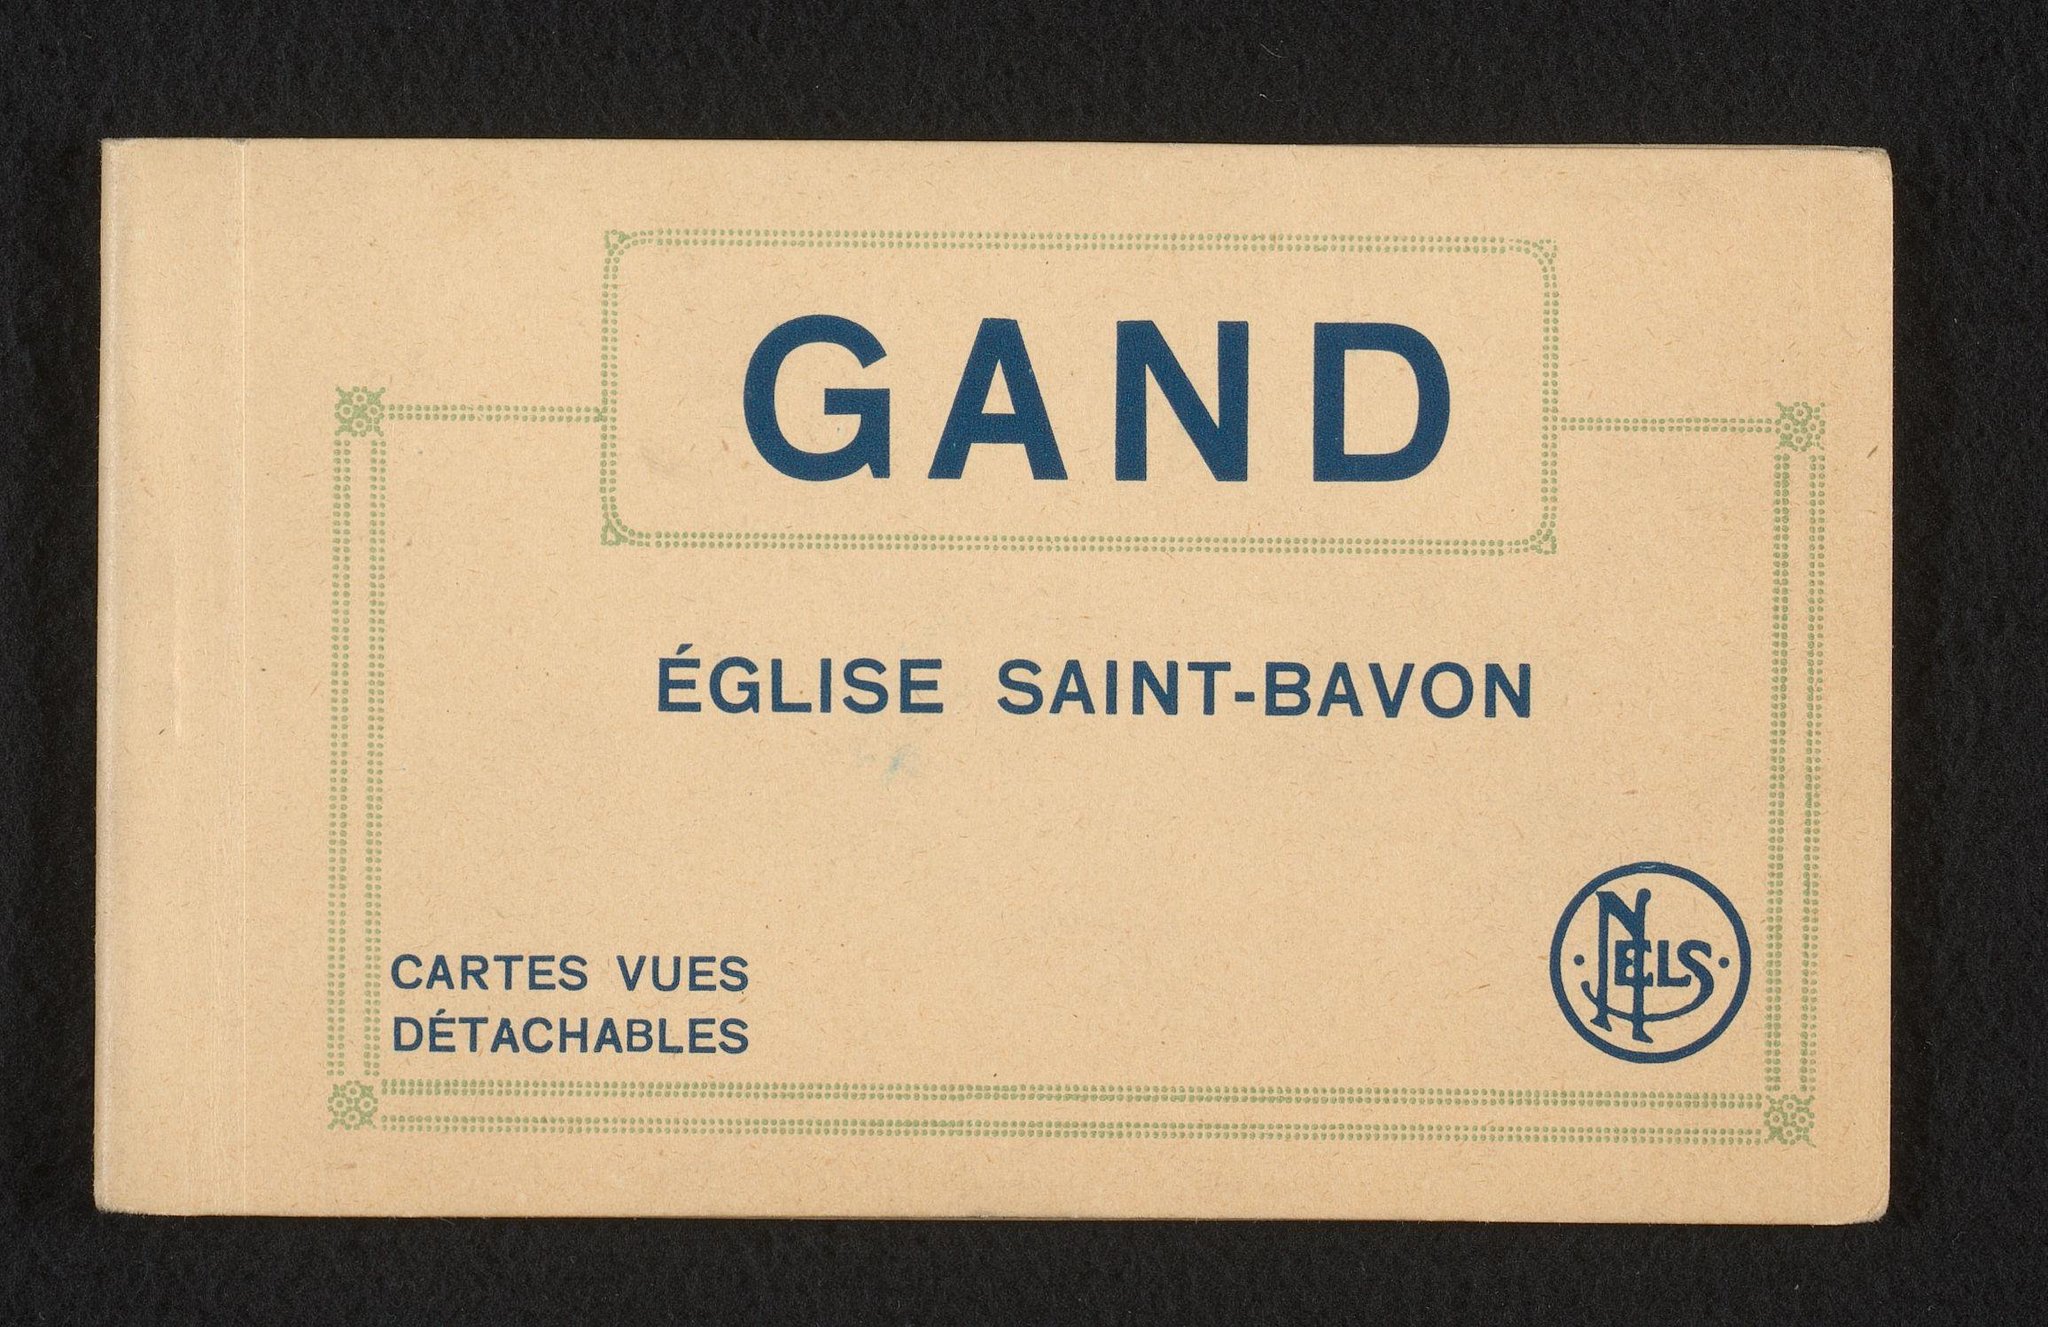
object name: album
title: Album met voorstellingen van de Sint-Bavo kerk in Gent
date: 1913-1930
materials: cardboard, paper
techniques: photograph, printing block, stapling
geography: brussels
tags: church (exterior), interior of church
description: Album met negen prentbriefkaarten van de Sint-Bavo kerk in Gent. De prentbriefkaarten kunnen eruit gescheurd worden.